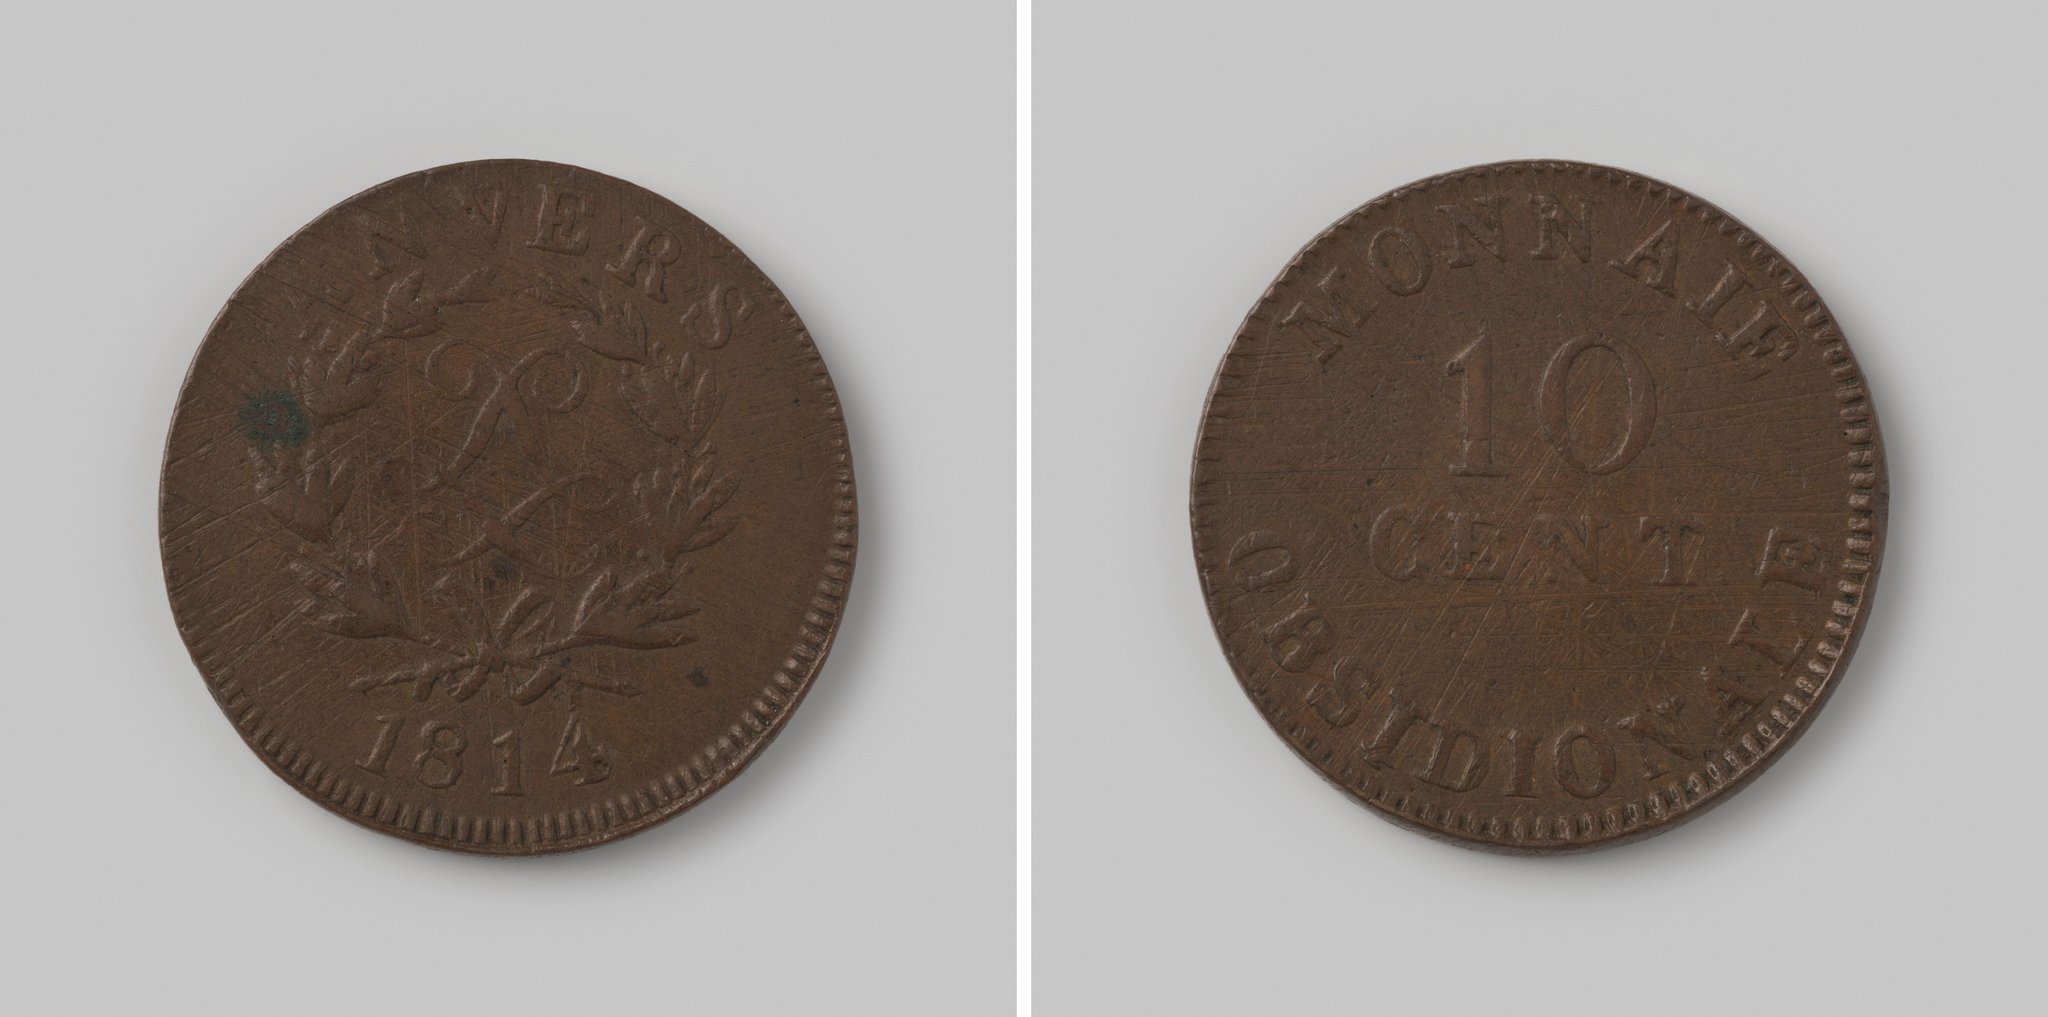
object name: coin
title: Tien centimes, noodmunt uit Antwerpen op naam van koning Lodewijk XVIII, 1814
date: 1814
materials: bronze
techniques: striking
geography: antwerp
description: Bronzen noodmunt. Voorzijde: binnen een krans van twee samengebonden takken tweemaal letter L in ligatuur. Bovenaan plaats-aanduiding: Anvers en onderaan jaartal. Keerzijde: waarde-aanduiding: 10 cent. in twee regels. Omschrift: Monnaie Obsidionale.